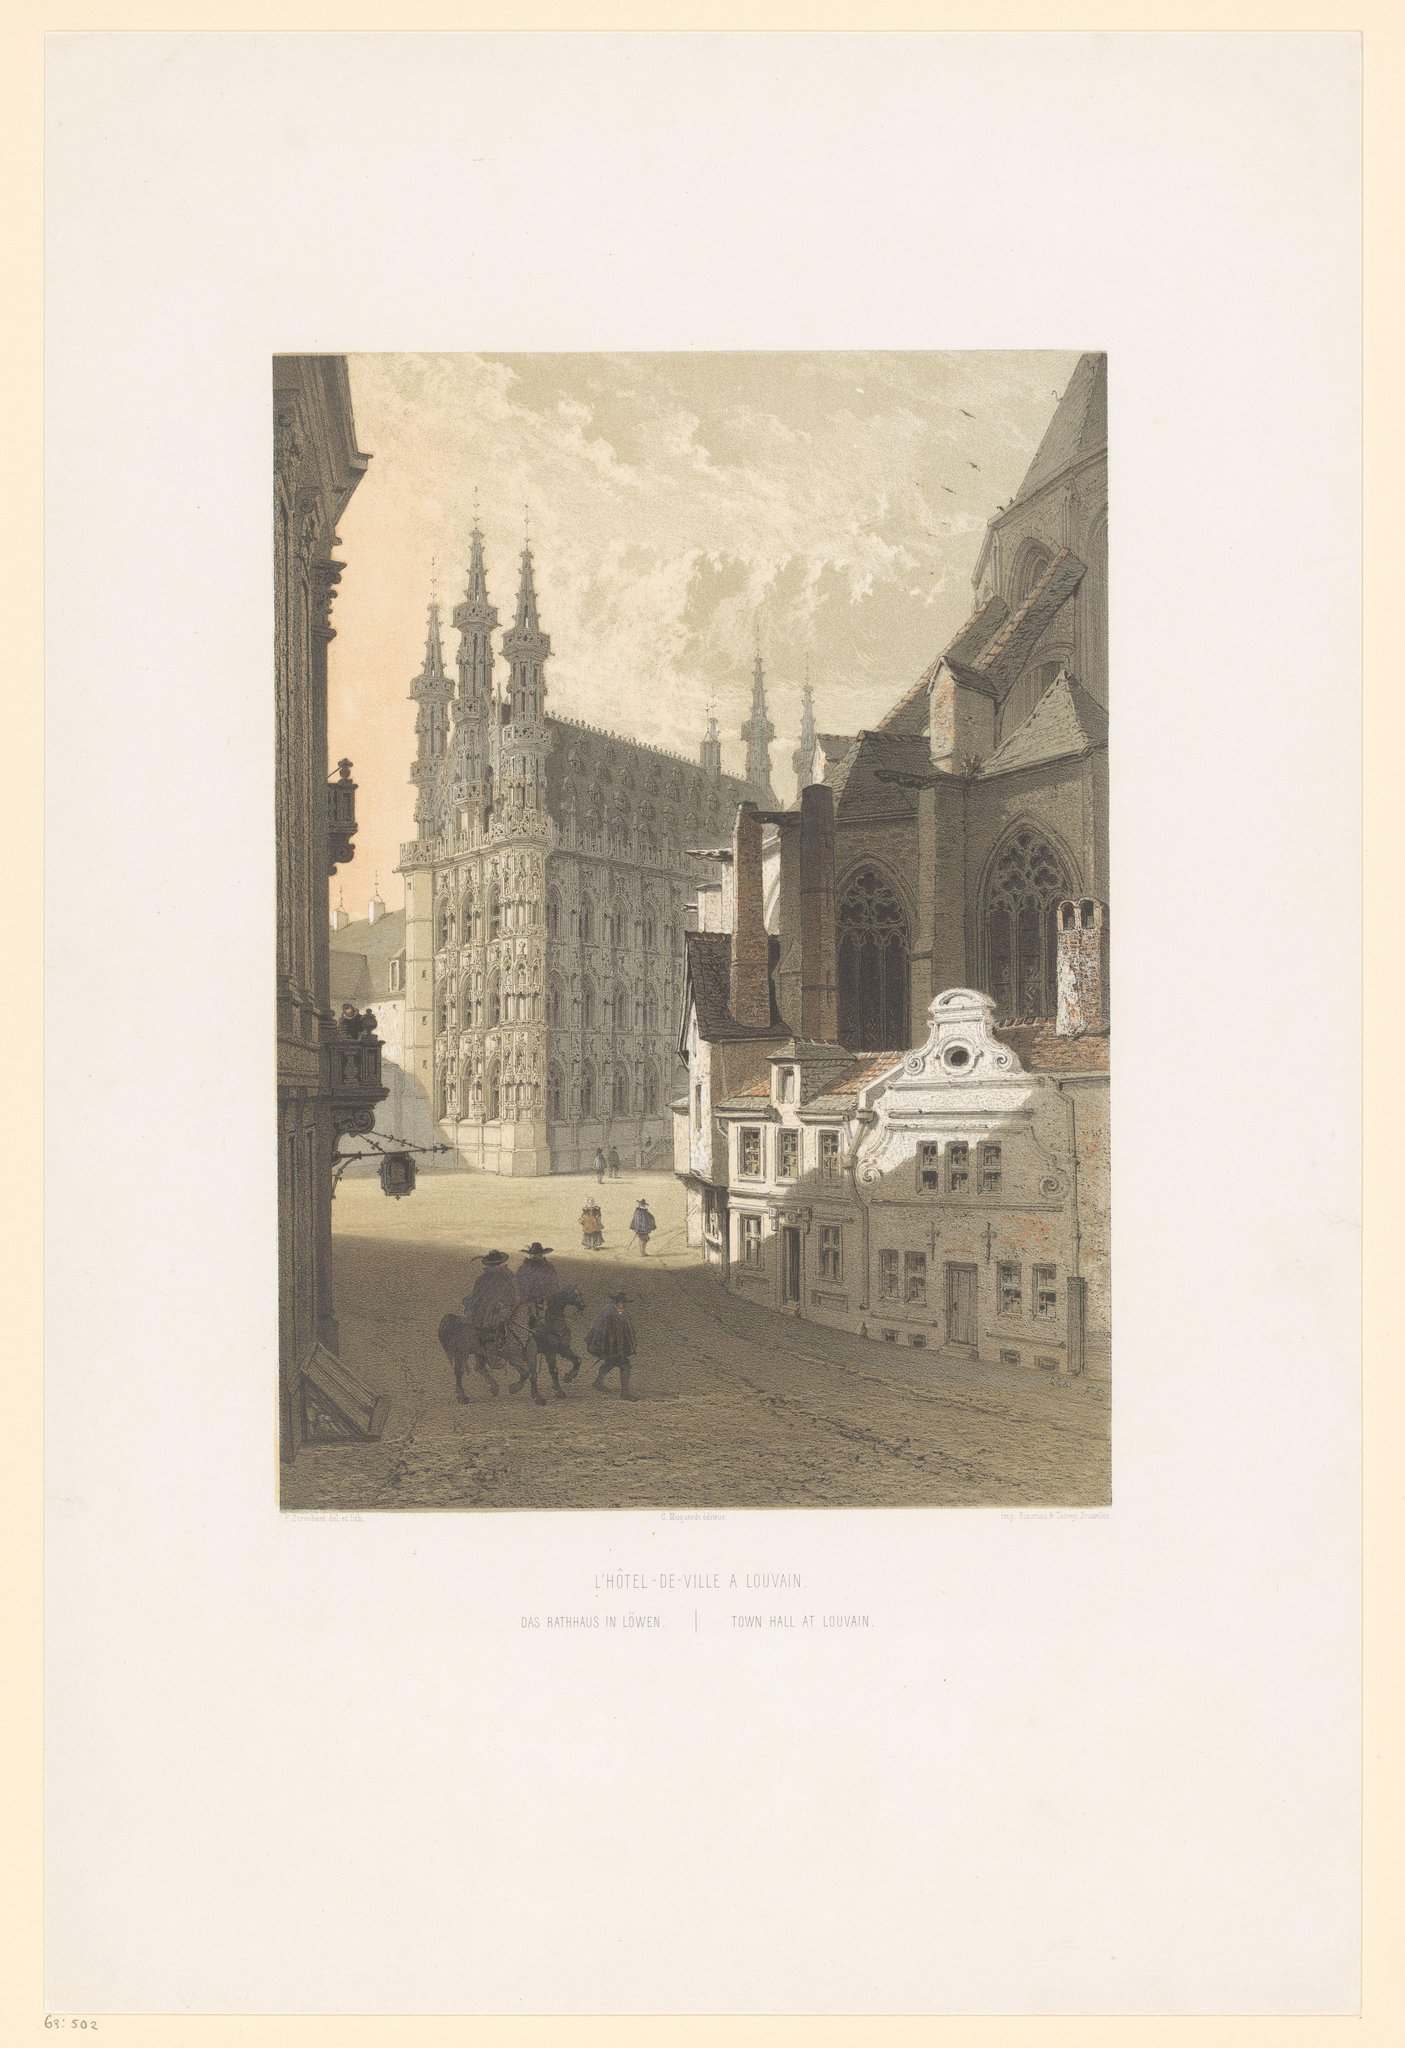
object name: print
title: L'hôtel-de-ville a Louvain / Das Rathhaus in Löwen / Town hall at Louvain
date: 1852-1878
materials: paper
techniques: lithograph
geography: brussels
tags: townhall, civic architecture; edifices; dwellings, city-view in general; 'veduta' (+ city(-scape) with figures, staffage)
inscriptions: collector's mark: Lugt 2228, collector's mark: Lugt 2760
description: Vanaf 1852 verschijnen de eerste afleveringen van deze serie, telkens in een set van drie platen voorzien van tekst door Félix Stappaerts. Later (vanaf 1854 tot en met 1878) worden deze prenten gebonden uitgegeven.